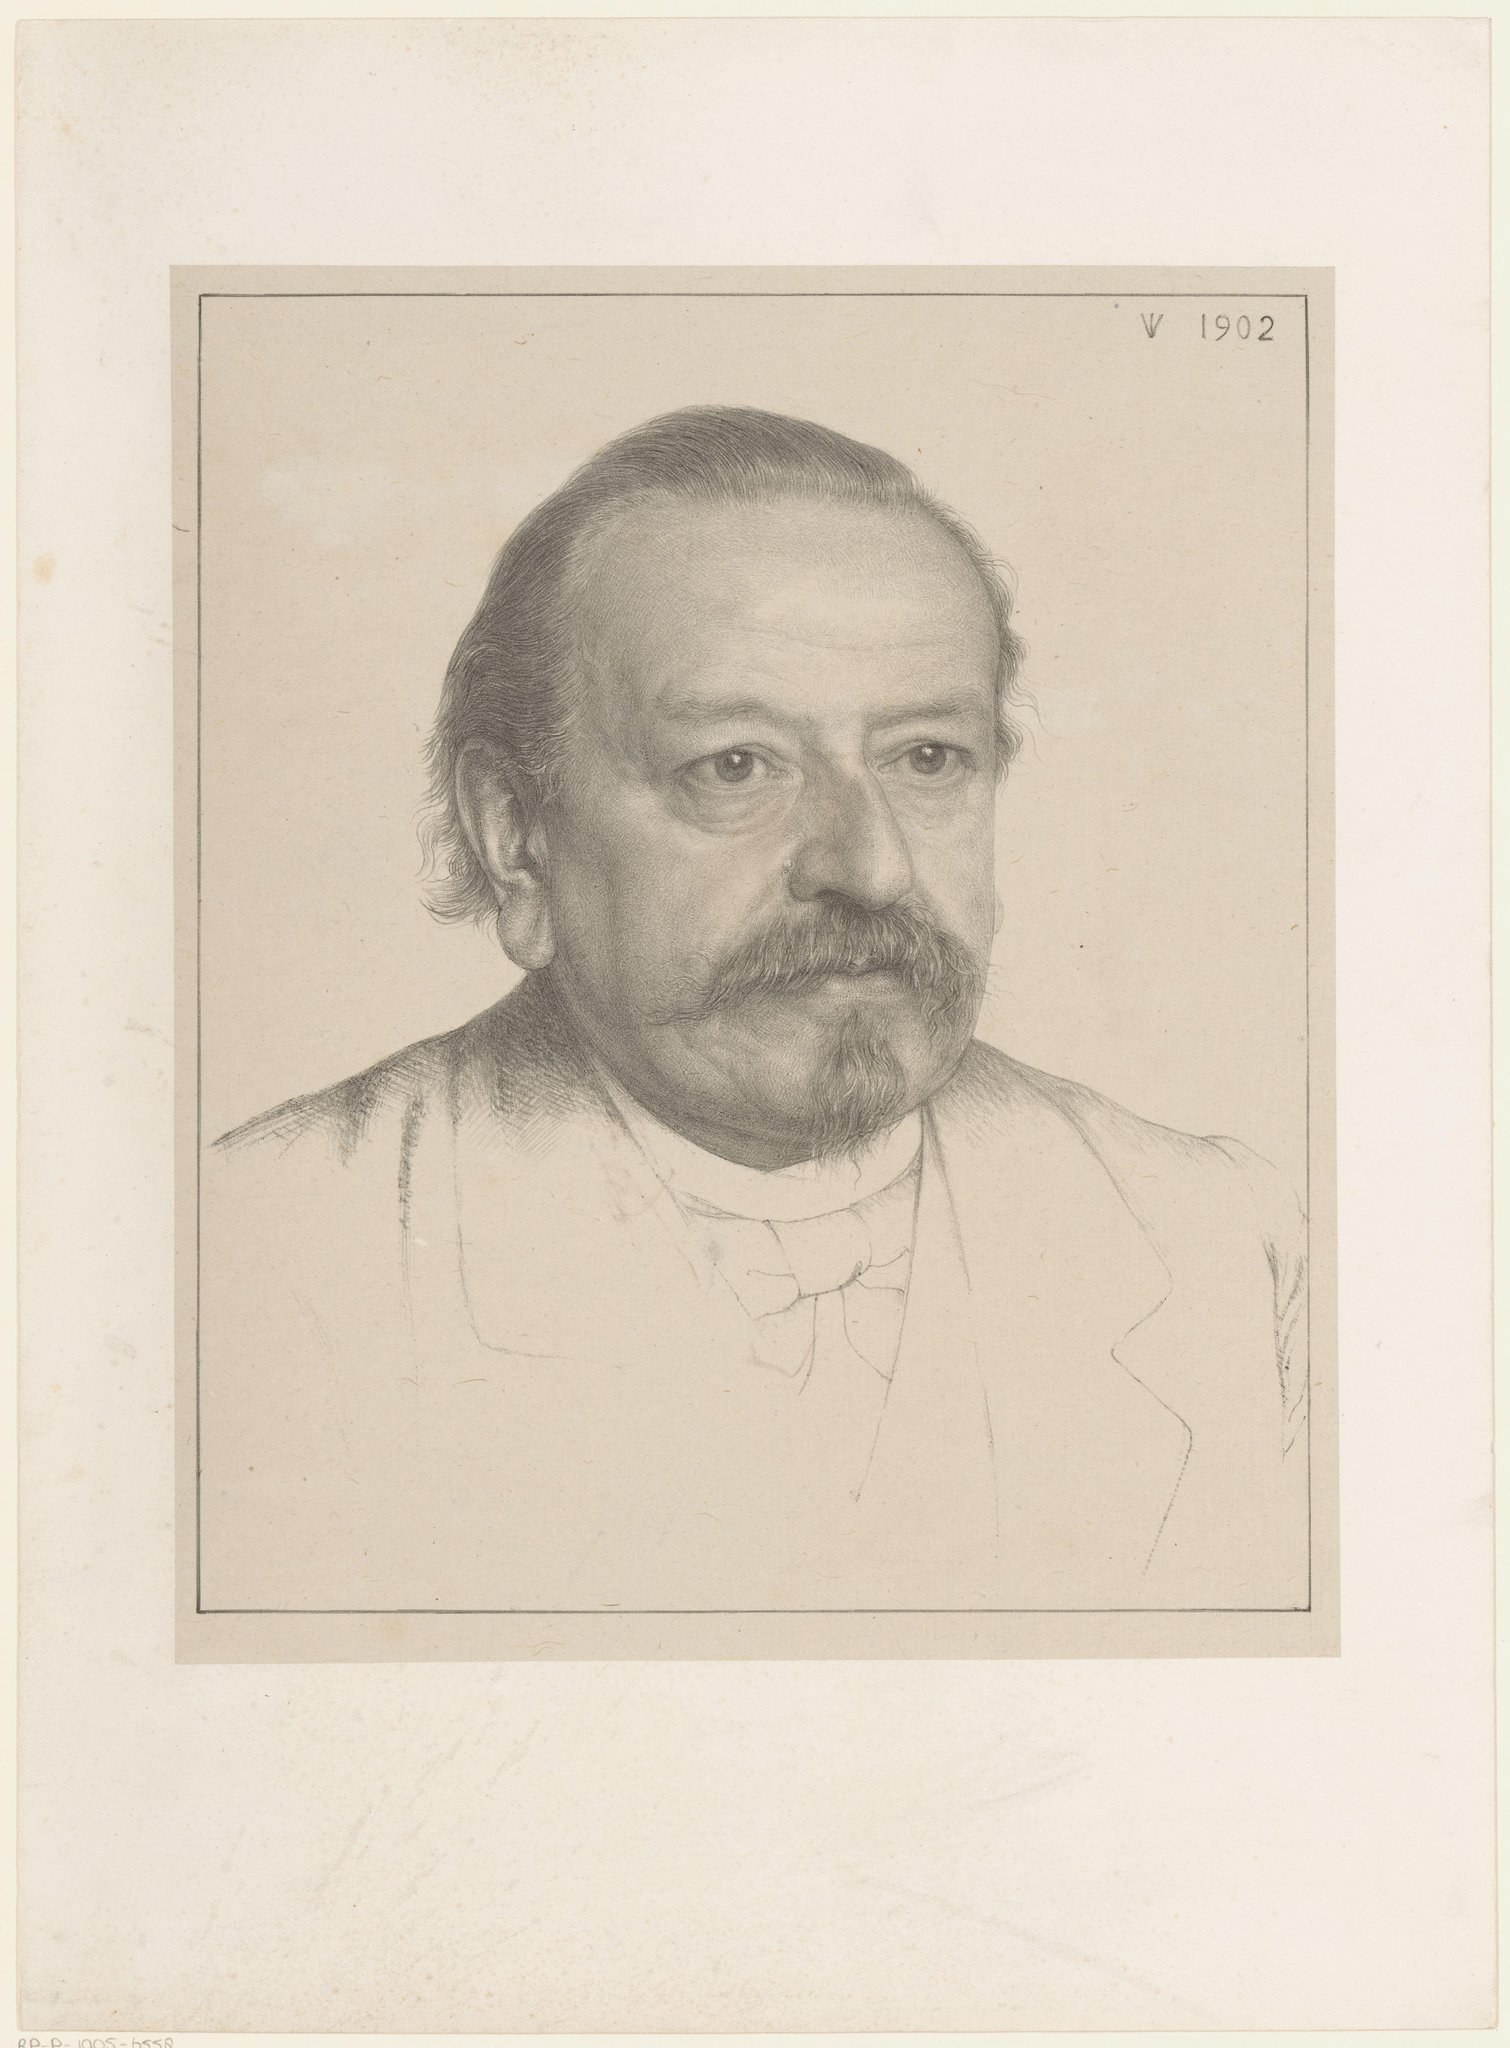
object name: print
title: Portret van Reinier Willem Petrus de Vries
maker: jan veth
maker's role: designer, draughtsman, painter, print maker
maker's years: 1864-1925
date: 1902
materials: paper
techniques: lithograph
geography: netherlands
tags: auctioneer, reinier willem petrus de vries (1841-1919), historical persons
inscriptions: collector's mark: Lugt 2228